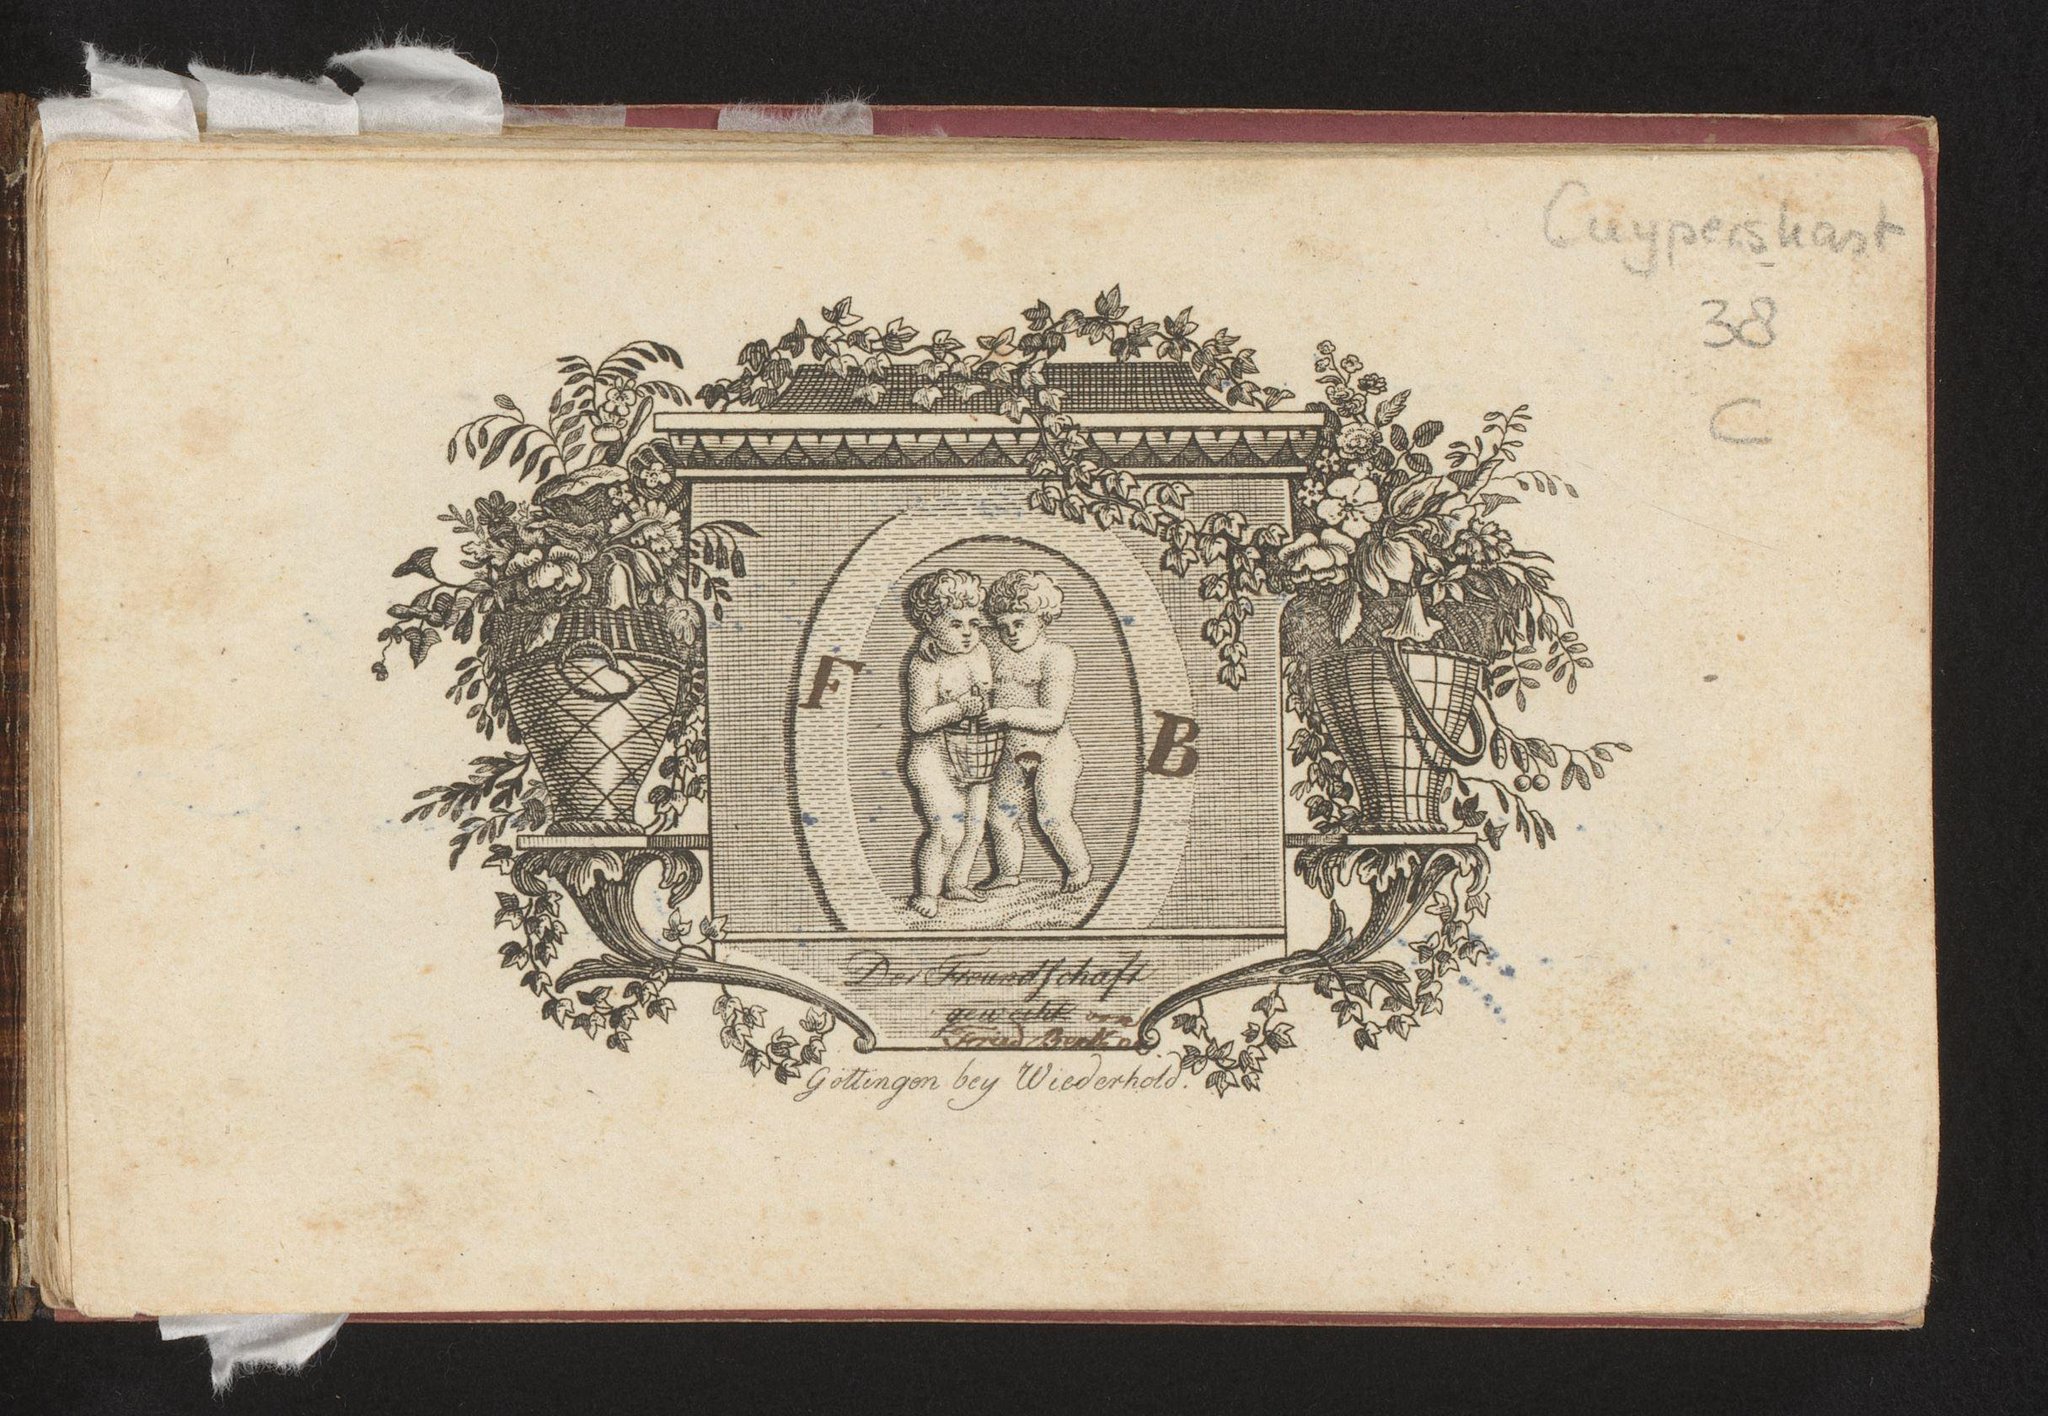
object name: print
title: Putti in een medaillon met twee Hoornen des overvloeds als omlijsting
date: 1770-1826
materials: ink, paper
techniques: etching, writing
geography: braunschweig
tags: 'cornucopia', horn of plenty, 'album amicorum', 'stammbuch', cupids: 'amores', 'amoretti', 'putti'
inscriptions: annotation: ‘von Fried Beck’, collector's mark: ‘FB’, stamp: ‘B’, collector's mark, : ‘Vor meiner lieber Mutter/ Johanna Mach/ geb: [...] Königstatte/ Braunschweig in Jahres 1908 [...]’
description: Tekst in het Duits met de handgeschreven opdracht op het verso.